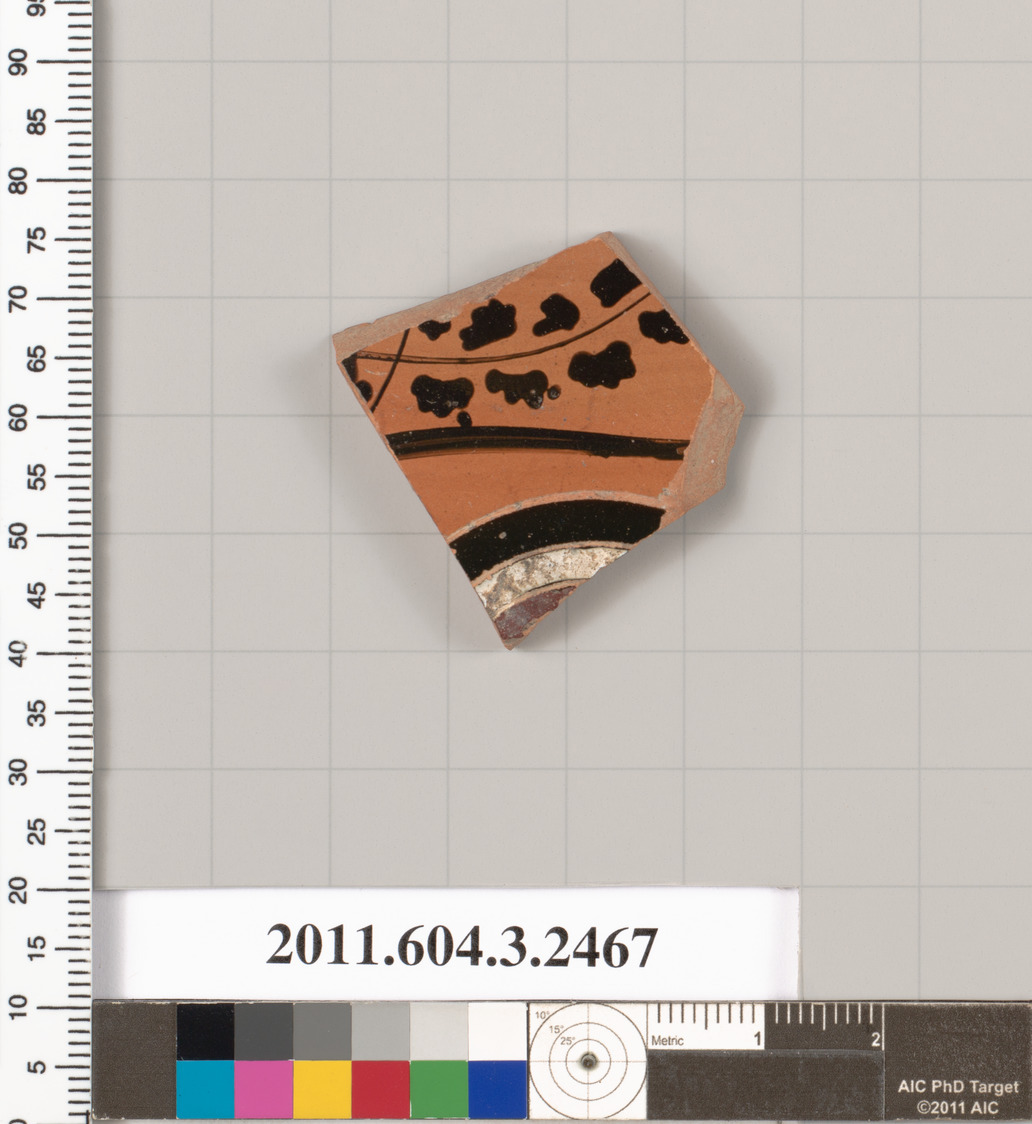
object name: kylix fragment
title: Terracotta fragment of a kylix: eye-cup (drinking cup)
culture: greek, attic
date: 520-510 BCE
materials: terracotta